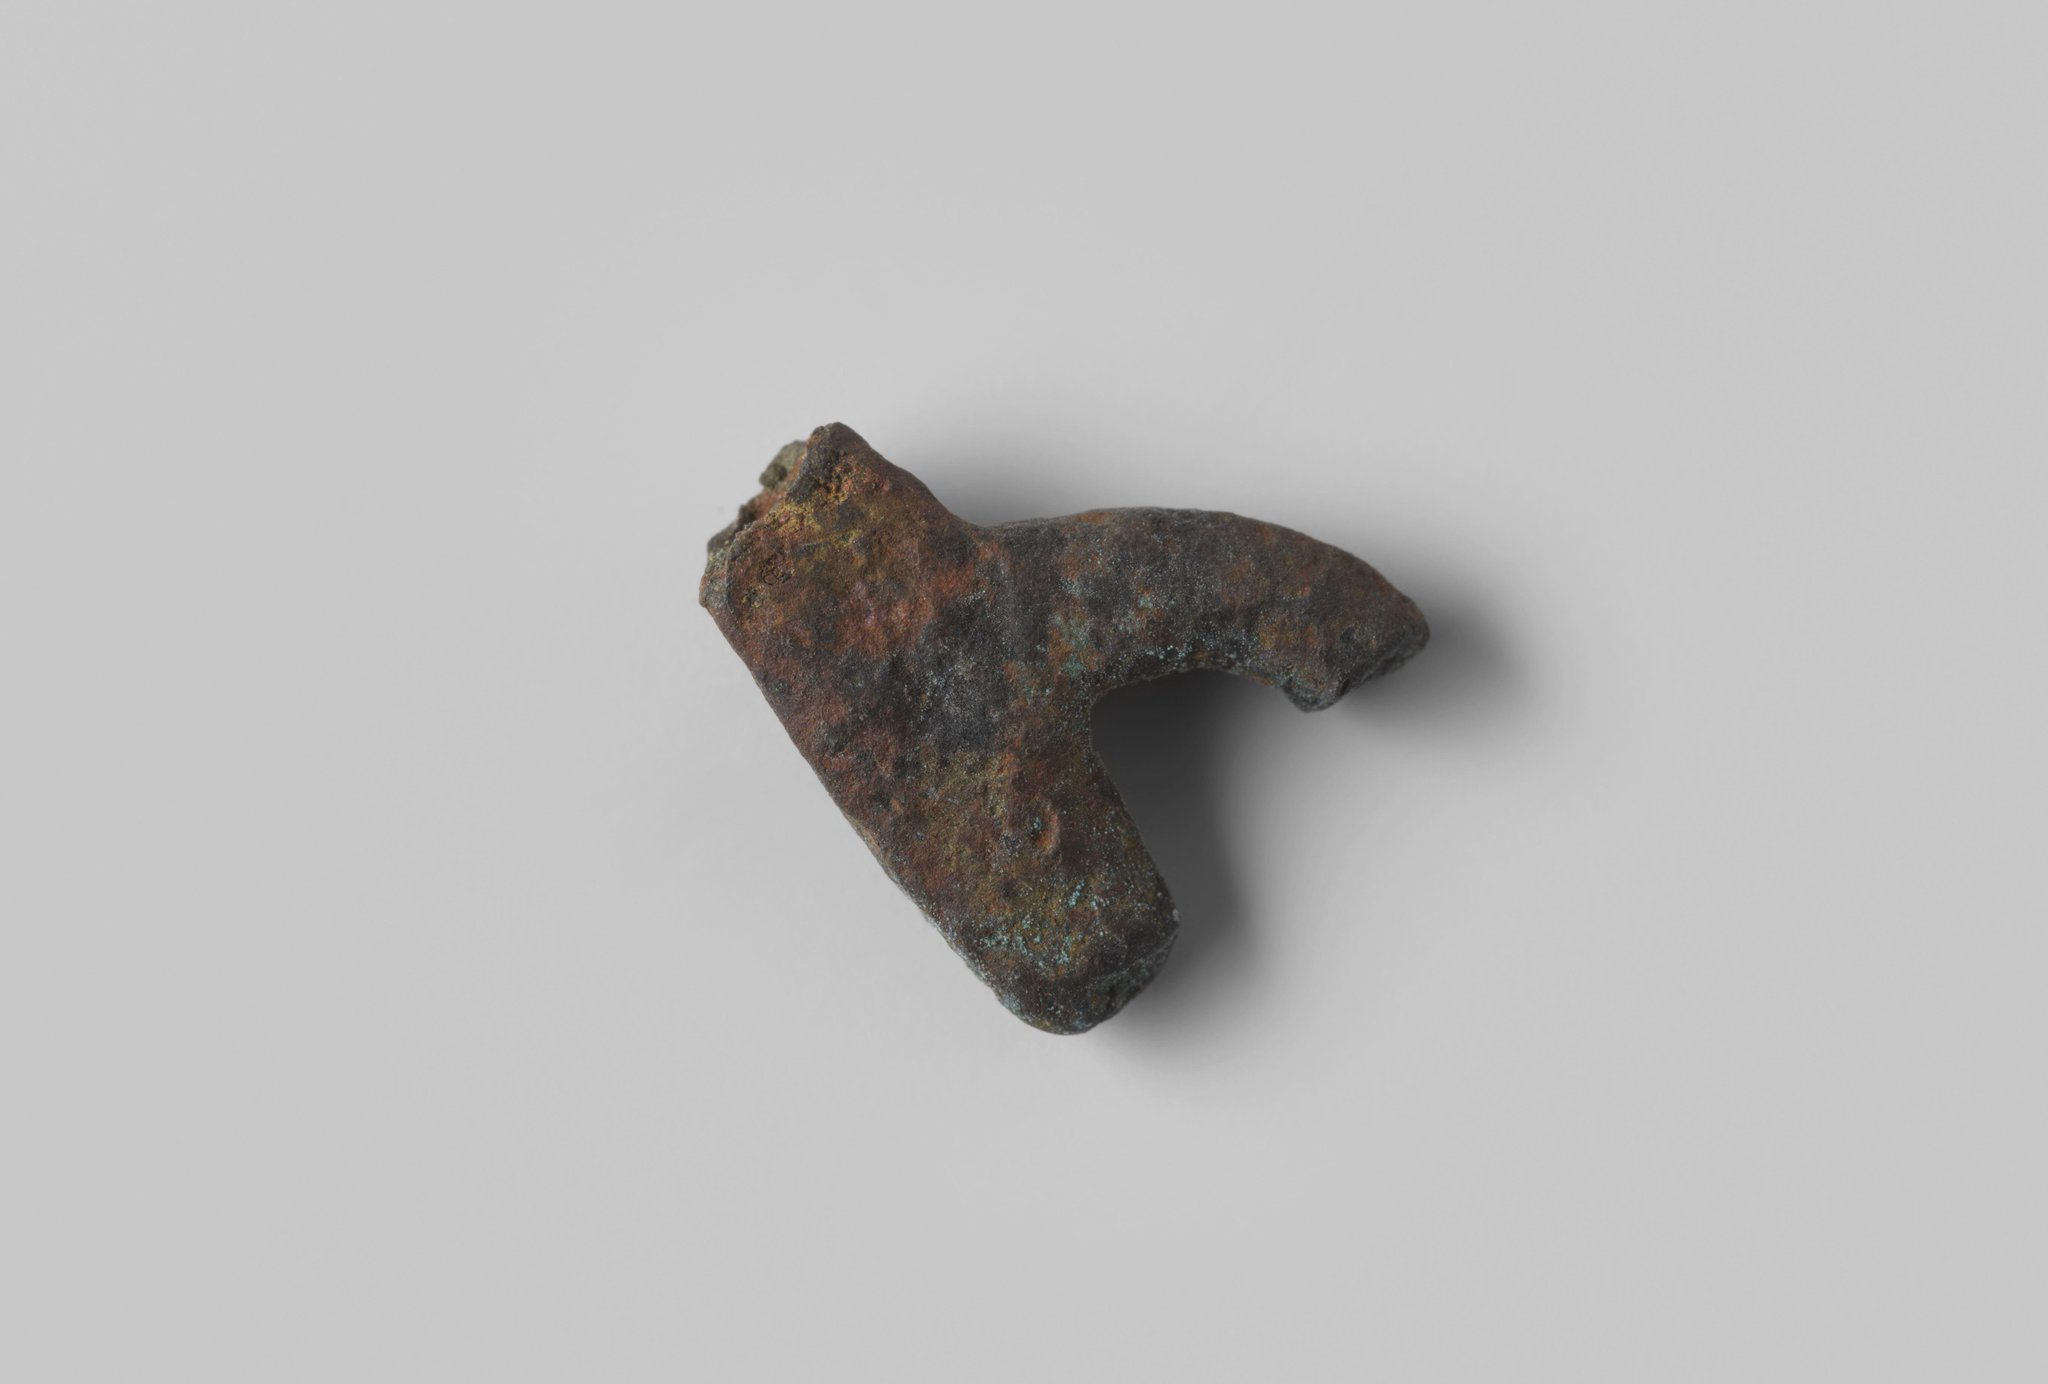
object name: belt buckle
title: Fragment riemgesp uit het wrak van de Oost-Indiëvaarder Hollandia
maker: Anonymous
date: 1700-1743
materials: copper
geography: netherlands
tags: verenigde oostindische compagnie, hollandia (schip), annet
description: D-shaped with pointed side, fragm of ring, id. NG 1980-27H384 belt buckle.